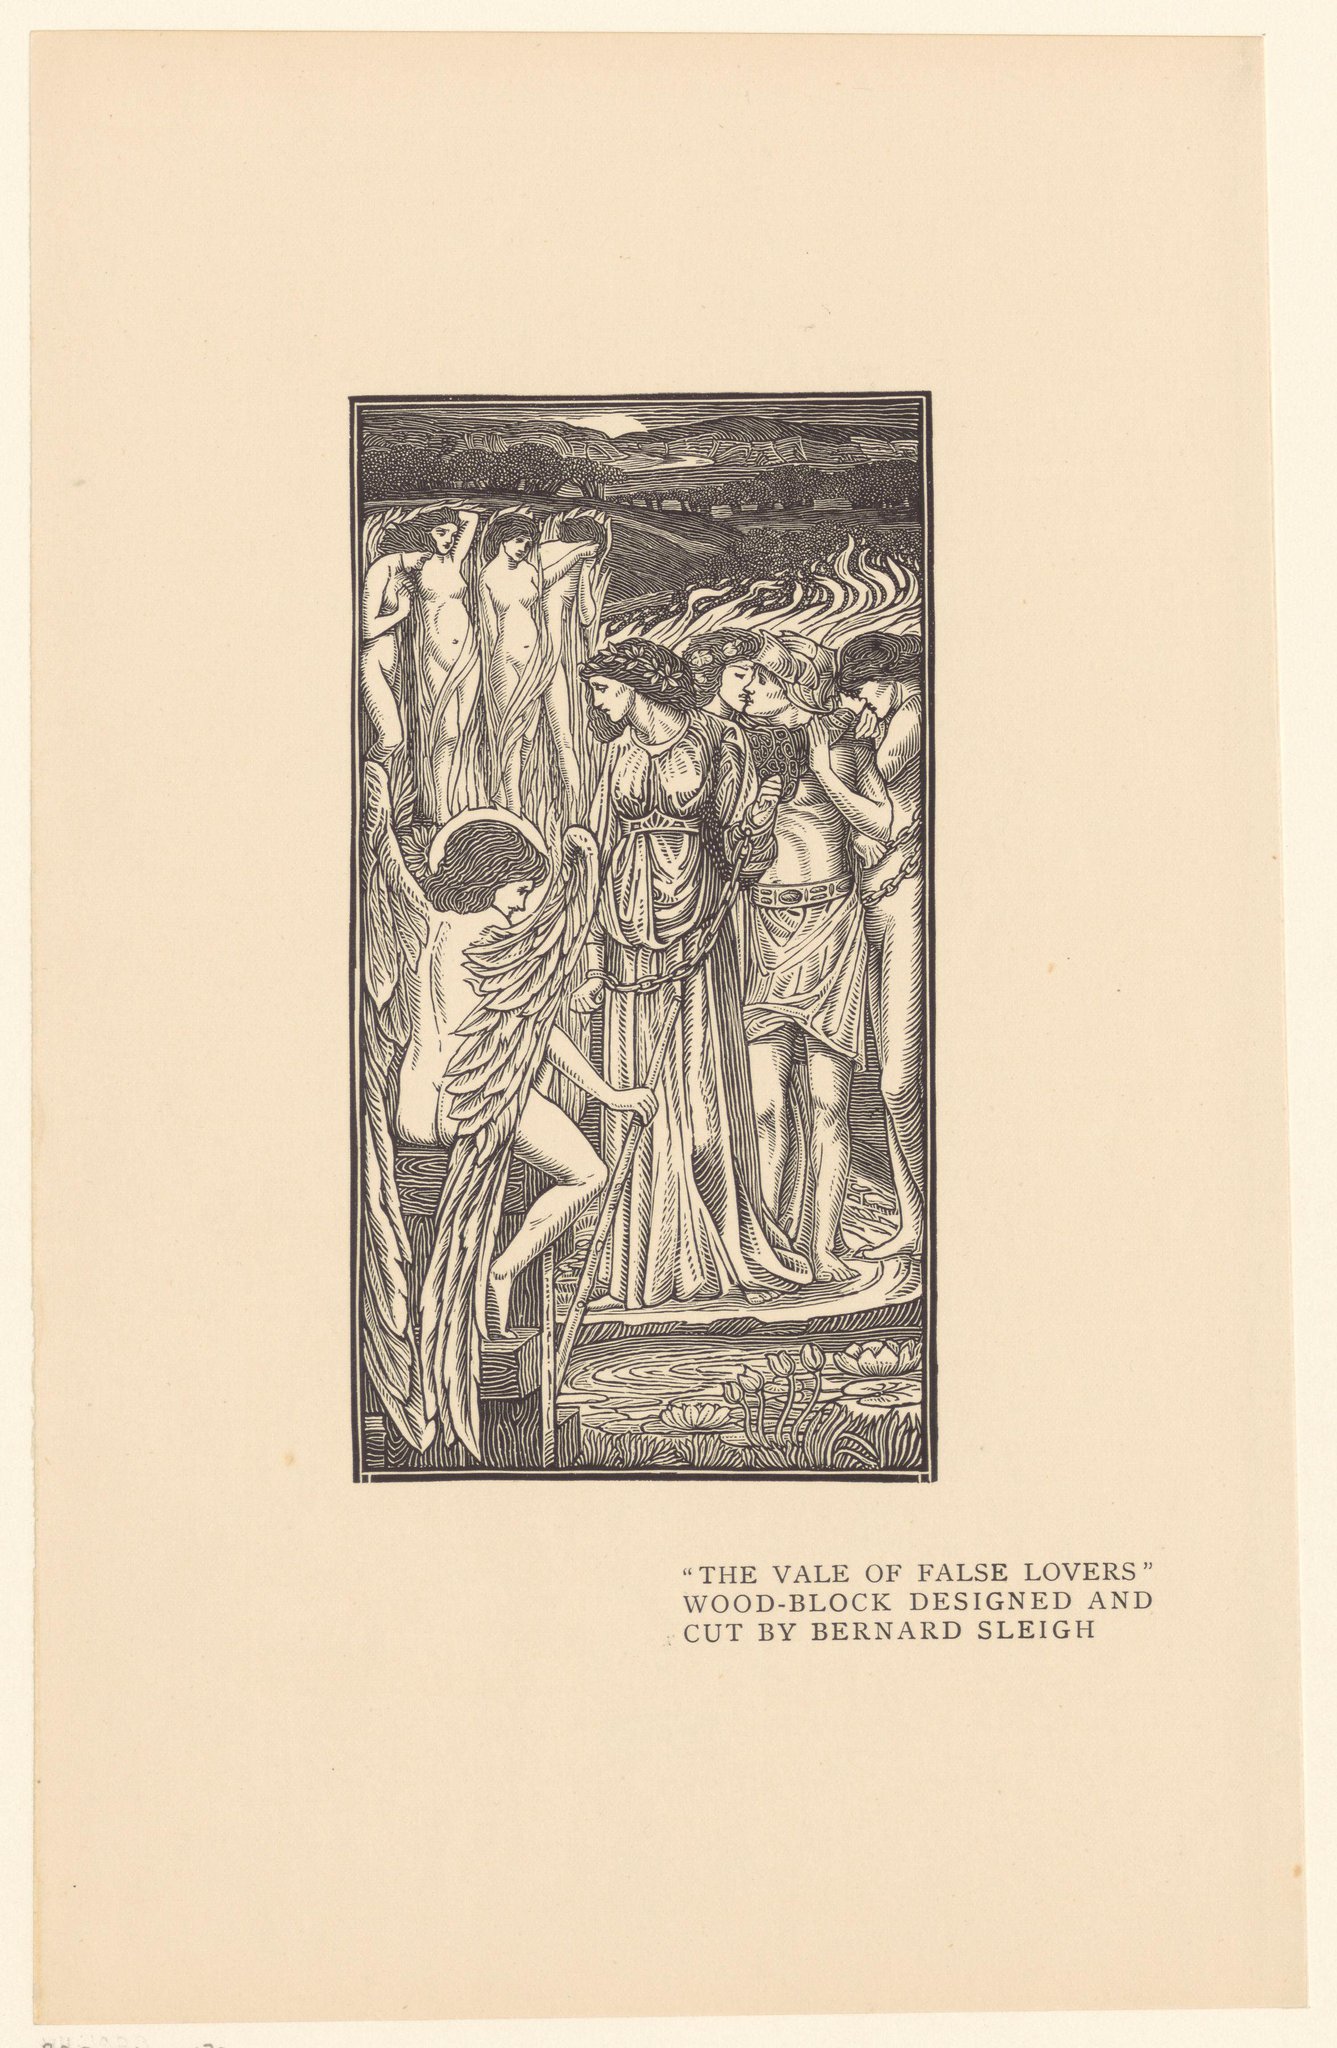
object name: print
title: Geketende figuren in een vallei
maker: bernard sleigh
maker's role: print maker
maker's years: 1872-1954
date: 1898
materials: paper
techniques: woodcut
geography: london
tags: dale, valley, (person) in fetters, not imprisoned, couple of lovers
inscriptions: collector's mark: Lugt 2228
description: Prent uit: The Studio 14 (1898), juni 1898.